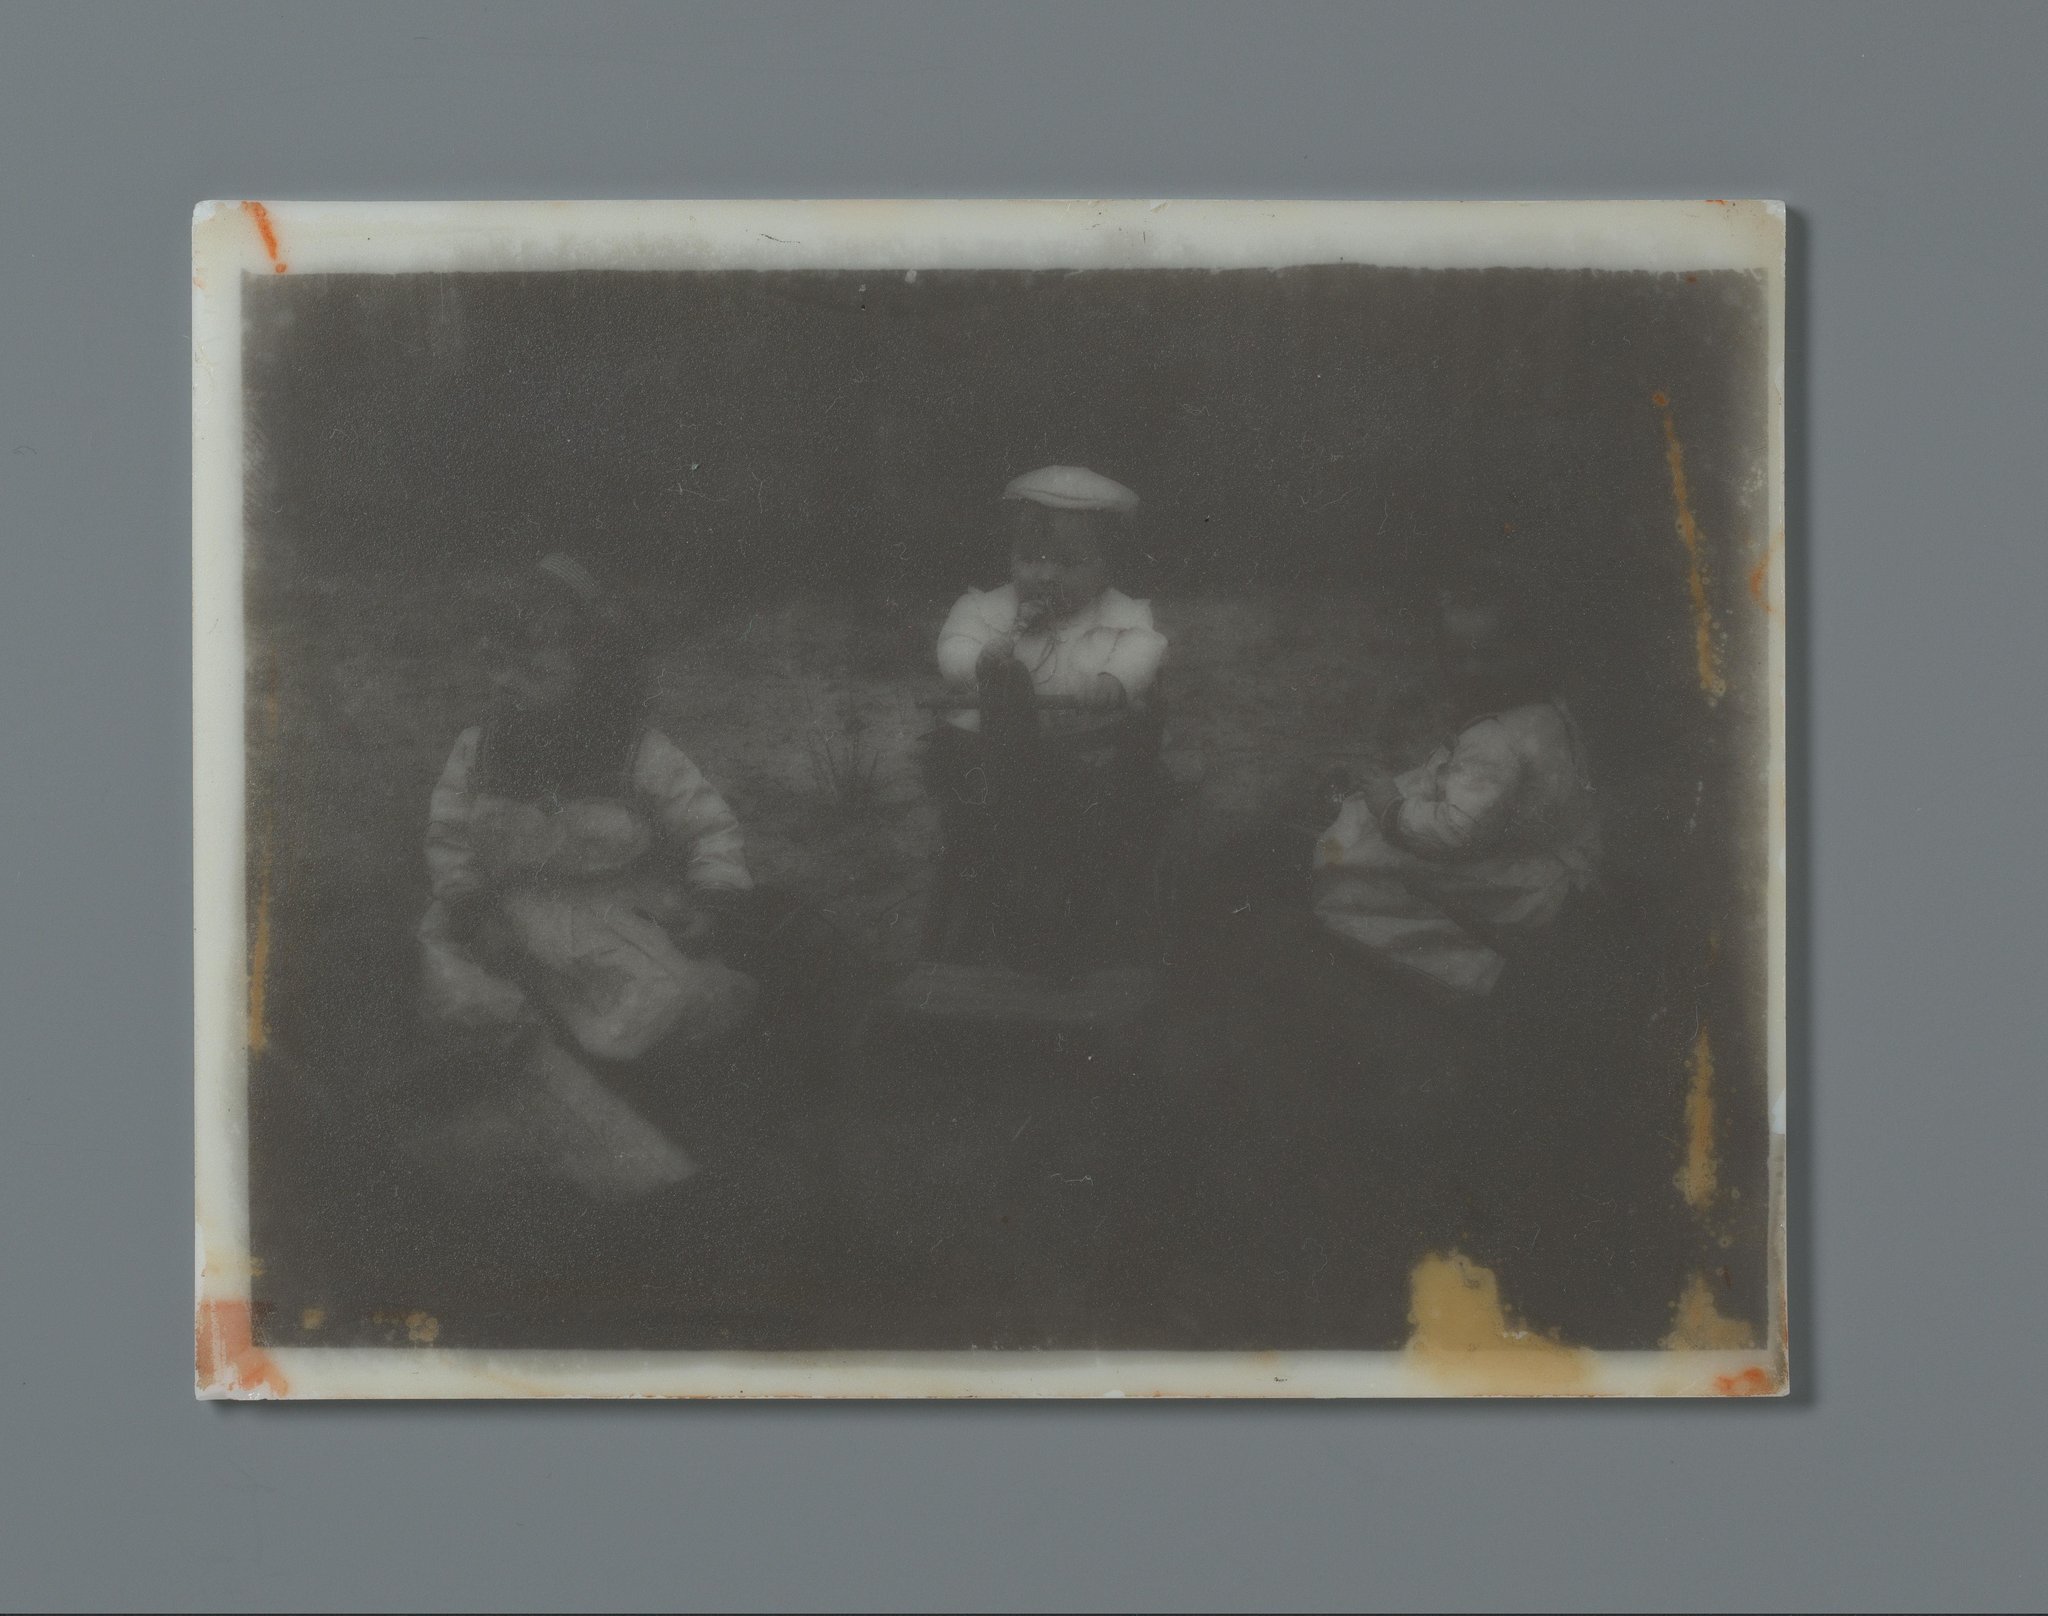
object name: photograph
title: Drie kleuters in een tuin met speelgoed, een hobbelpaard en kruiwagens met een schop, waarschijnlijk de tweeling Ad (links) en Johanna (rechts), en Han (midden) van der Kop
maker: willem carel van der kop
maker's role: amateurfotograaf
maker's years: 1869-1924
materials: glass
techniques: gelatin silver print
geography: schoonhoven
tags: adrianus johannes van der kop (ad), amsterdam, painter, draughtsman, (playing with) toys, tot, toddler ~ the ages of man